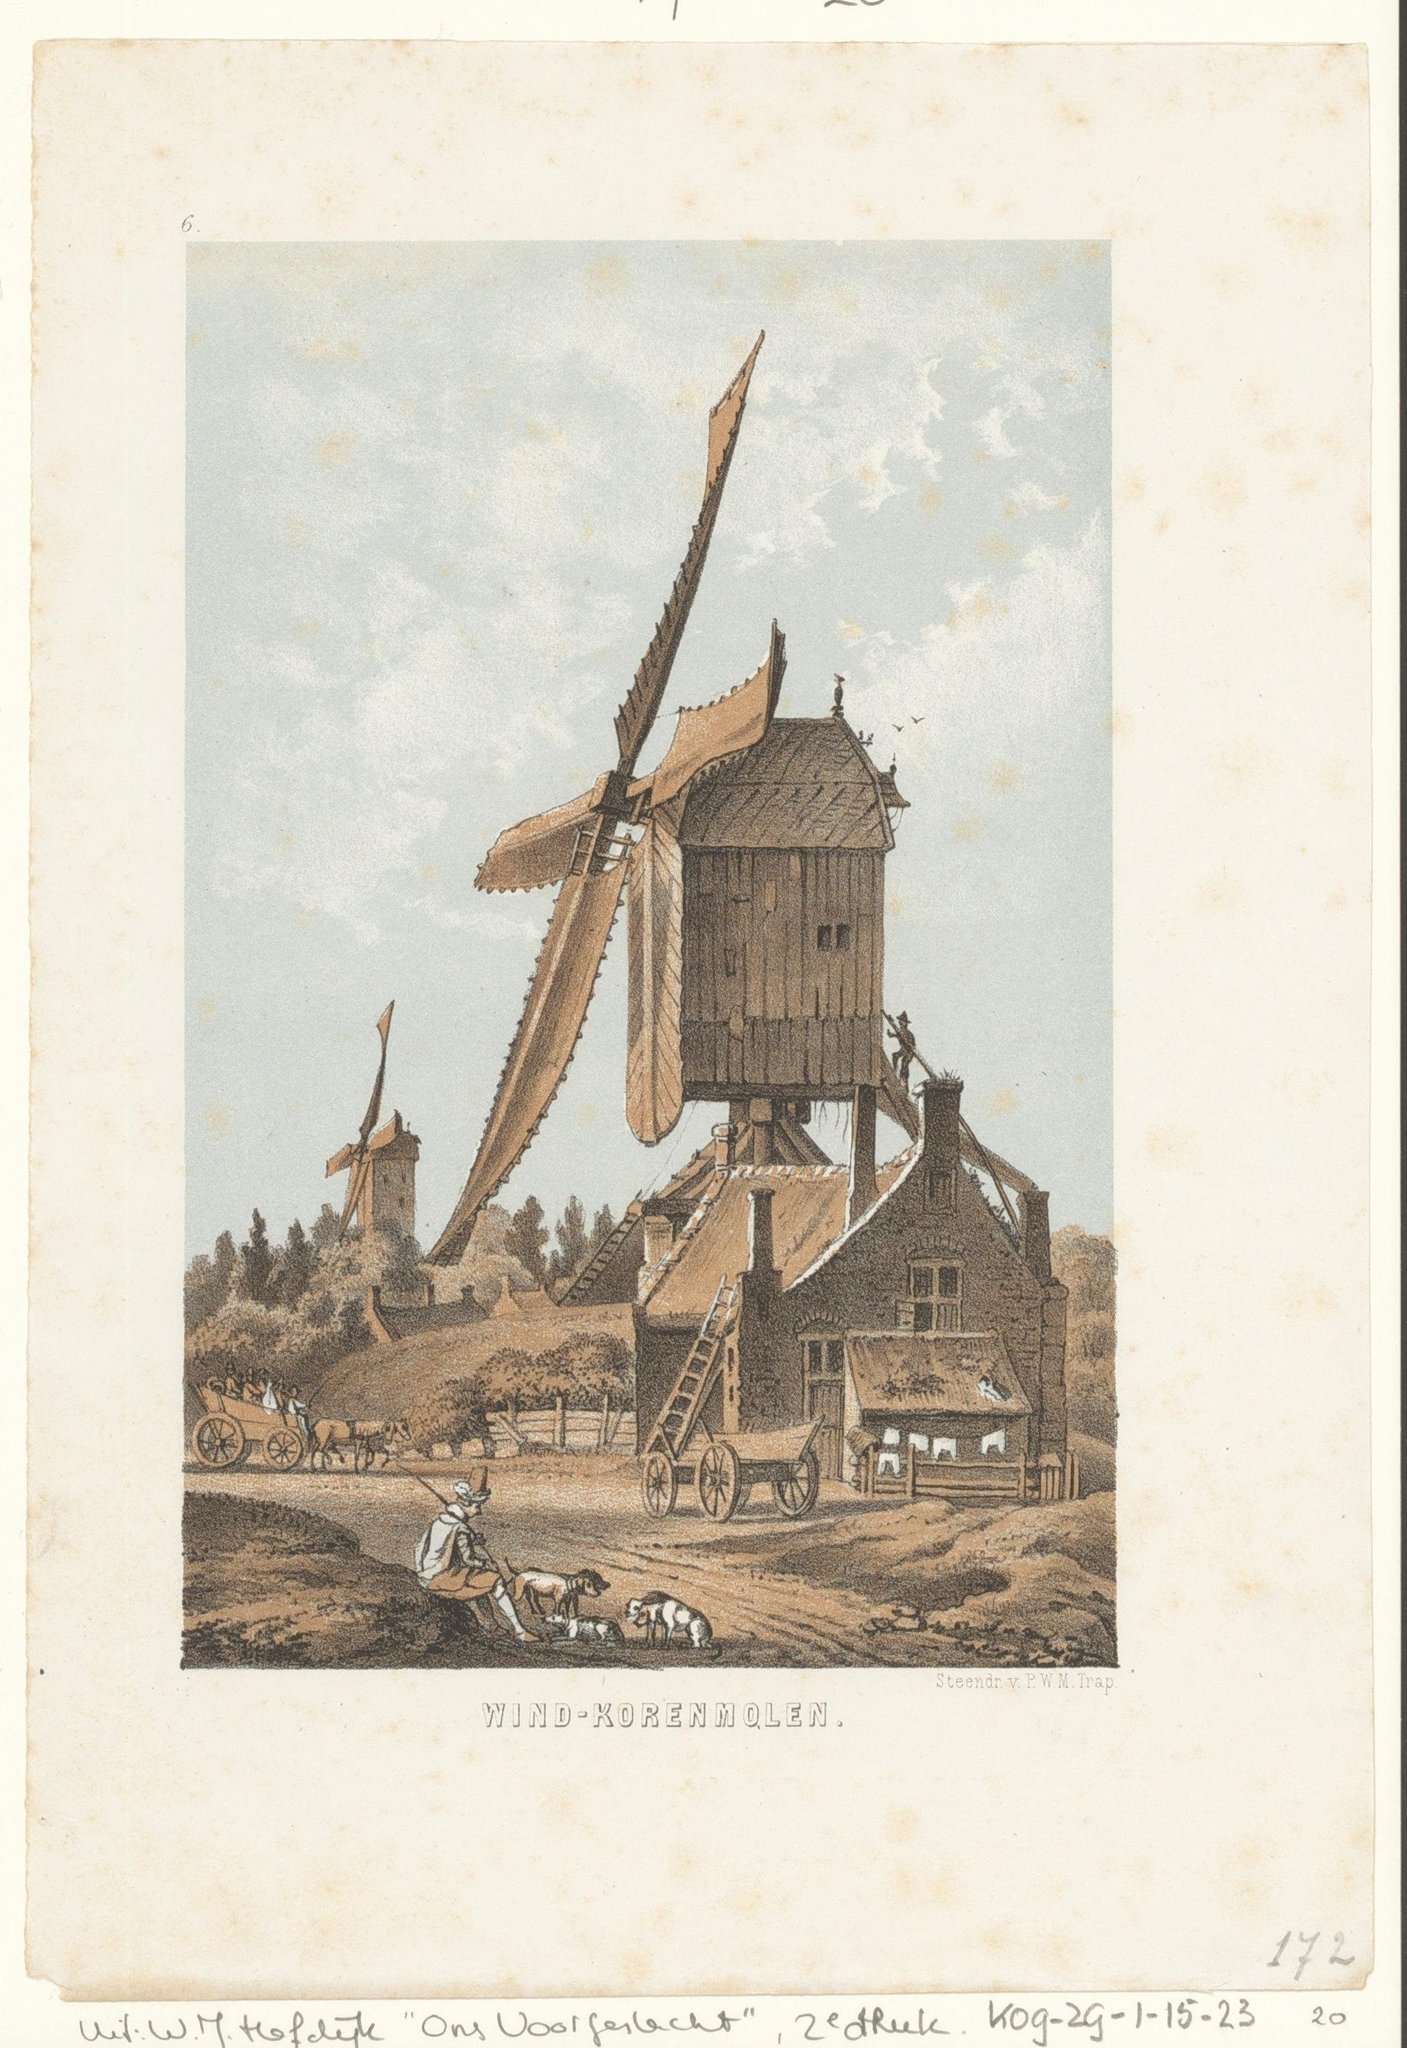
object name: print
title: Wind-korenmolen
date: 1873-1875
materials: paper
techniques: tone lithography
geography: leiden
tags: windmill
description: Prent waarschijnlijk uit: Hofdijk, W.J. Ons voorgeslacht in zijn dagelyksch leven geschilderd. Tweede druk. Leiden: P. van Santen, ca. 1875.